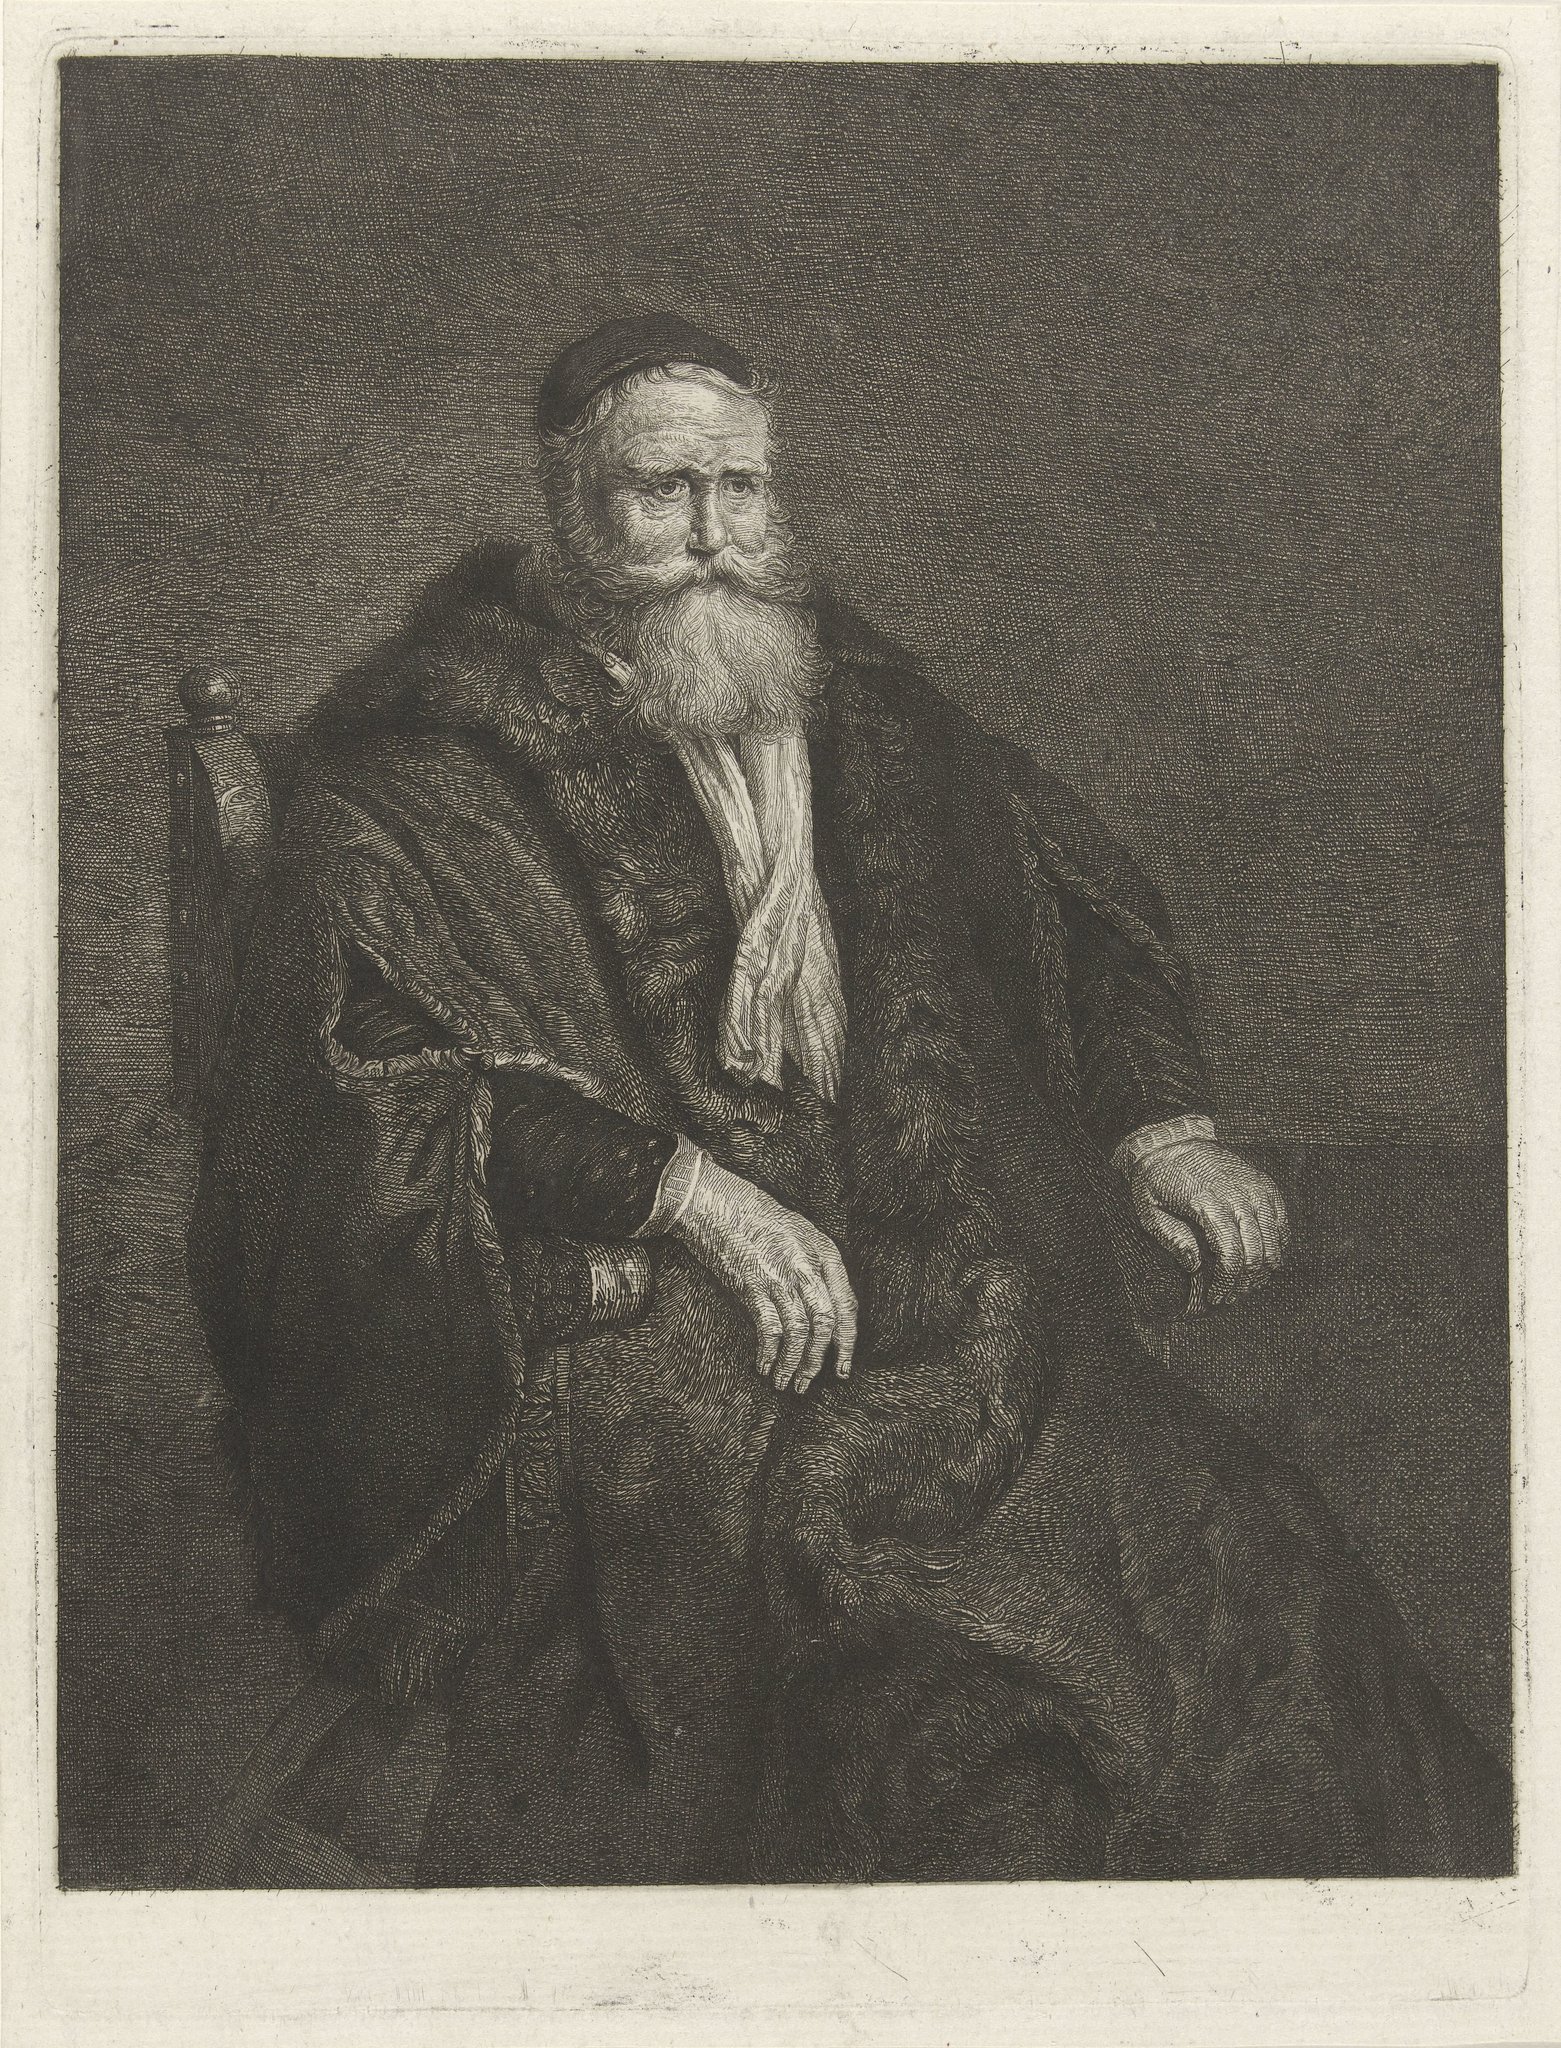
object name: print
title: Portret van een onbekende oude man in een leunstoel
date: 1801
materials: paper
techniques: etching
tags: sitting figure, old man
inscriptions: collector's mark: Lugt 2228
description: Portret van een onbekende oude man in een leunstoel. Kniestuk, zittend naar rechts gedraaid. Zijn armen rusten op de stoelleuningen. De man is gehuld in een met bont omzoomde mantel en draagt een hoofddeksel.